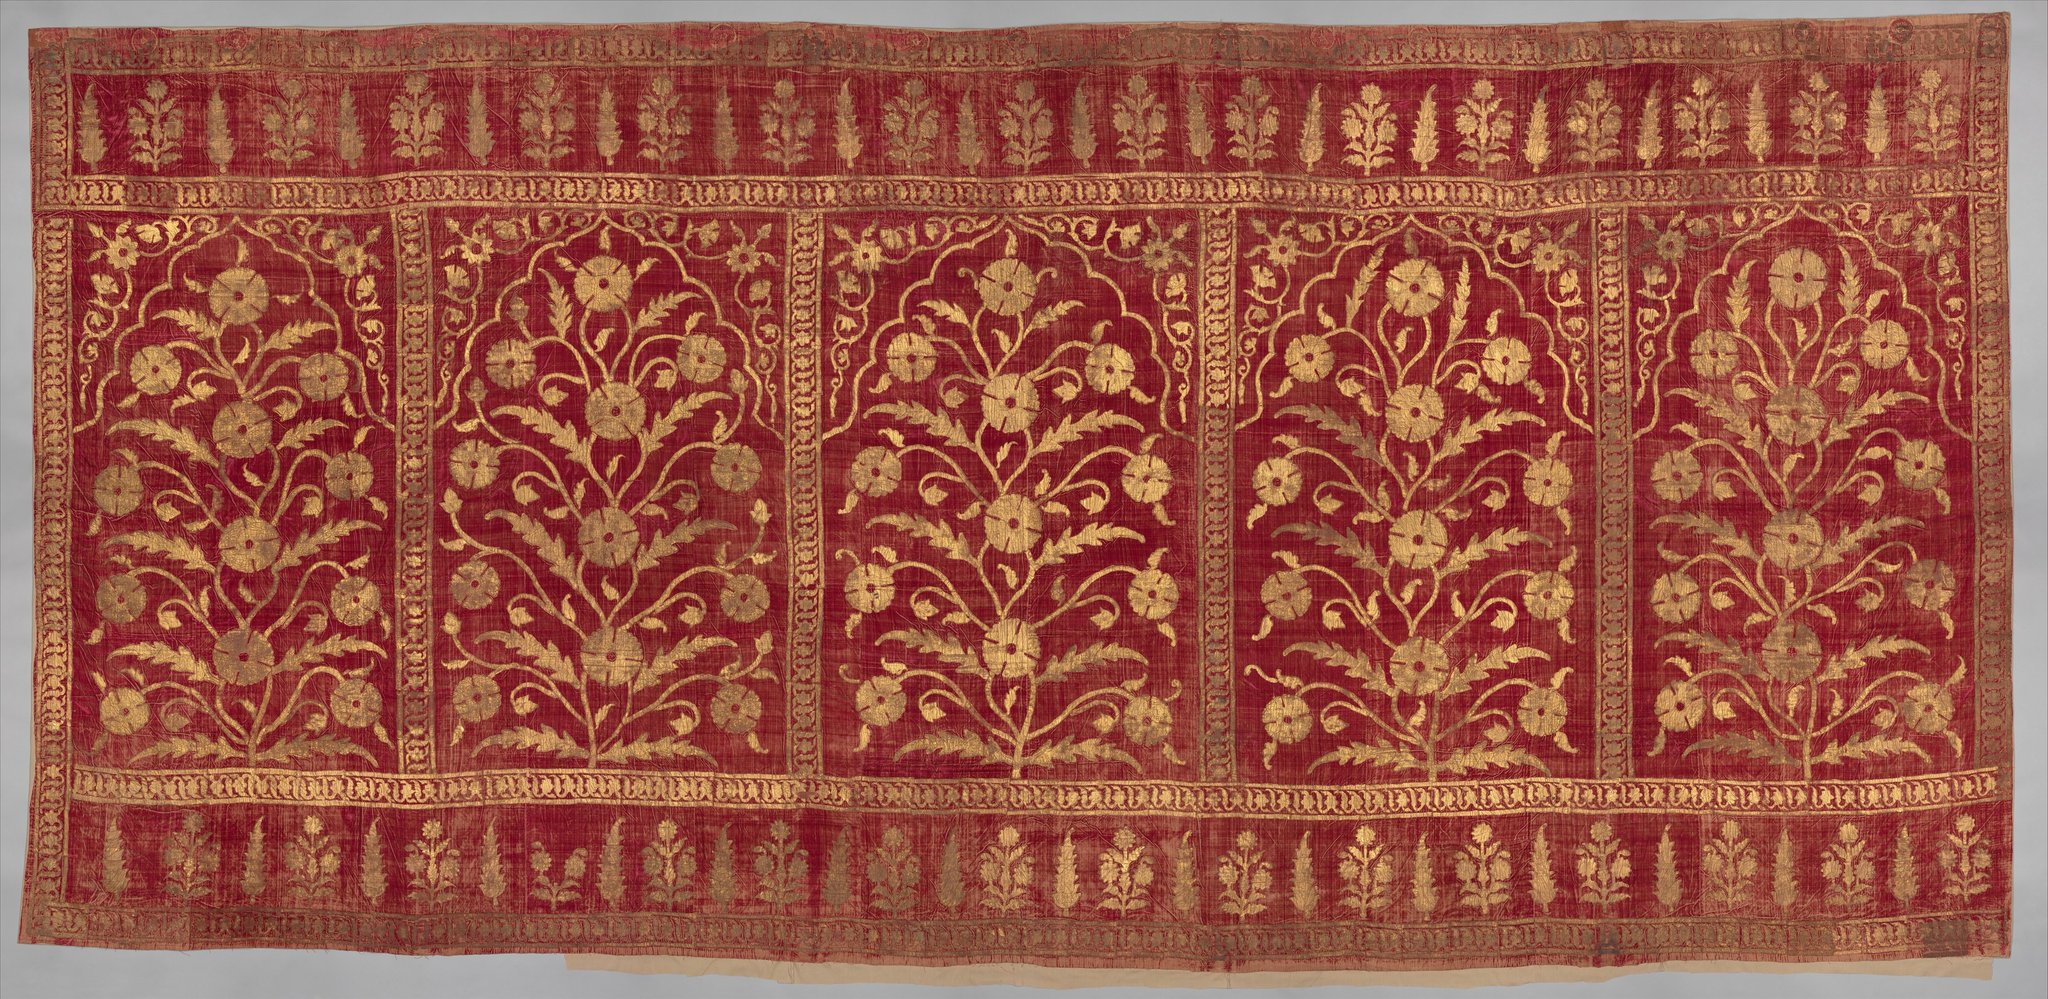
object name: tent lining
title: Floral Tent Panel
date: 1635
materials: gold, silk, velvet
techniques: cutting, painting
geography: india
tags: poppies